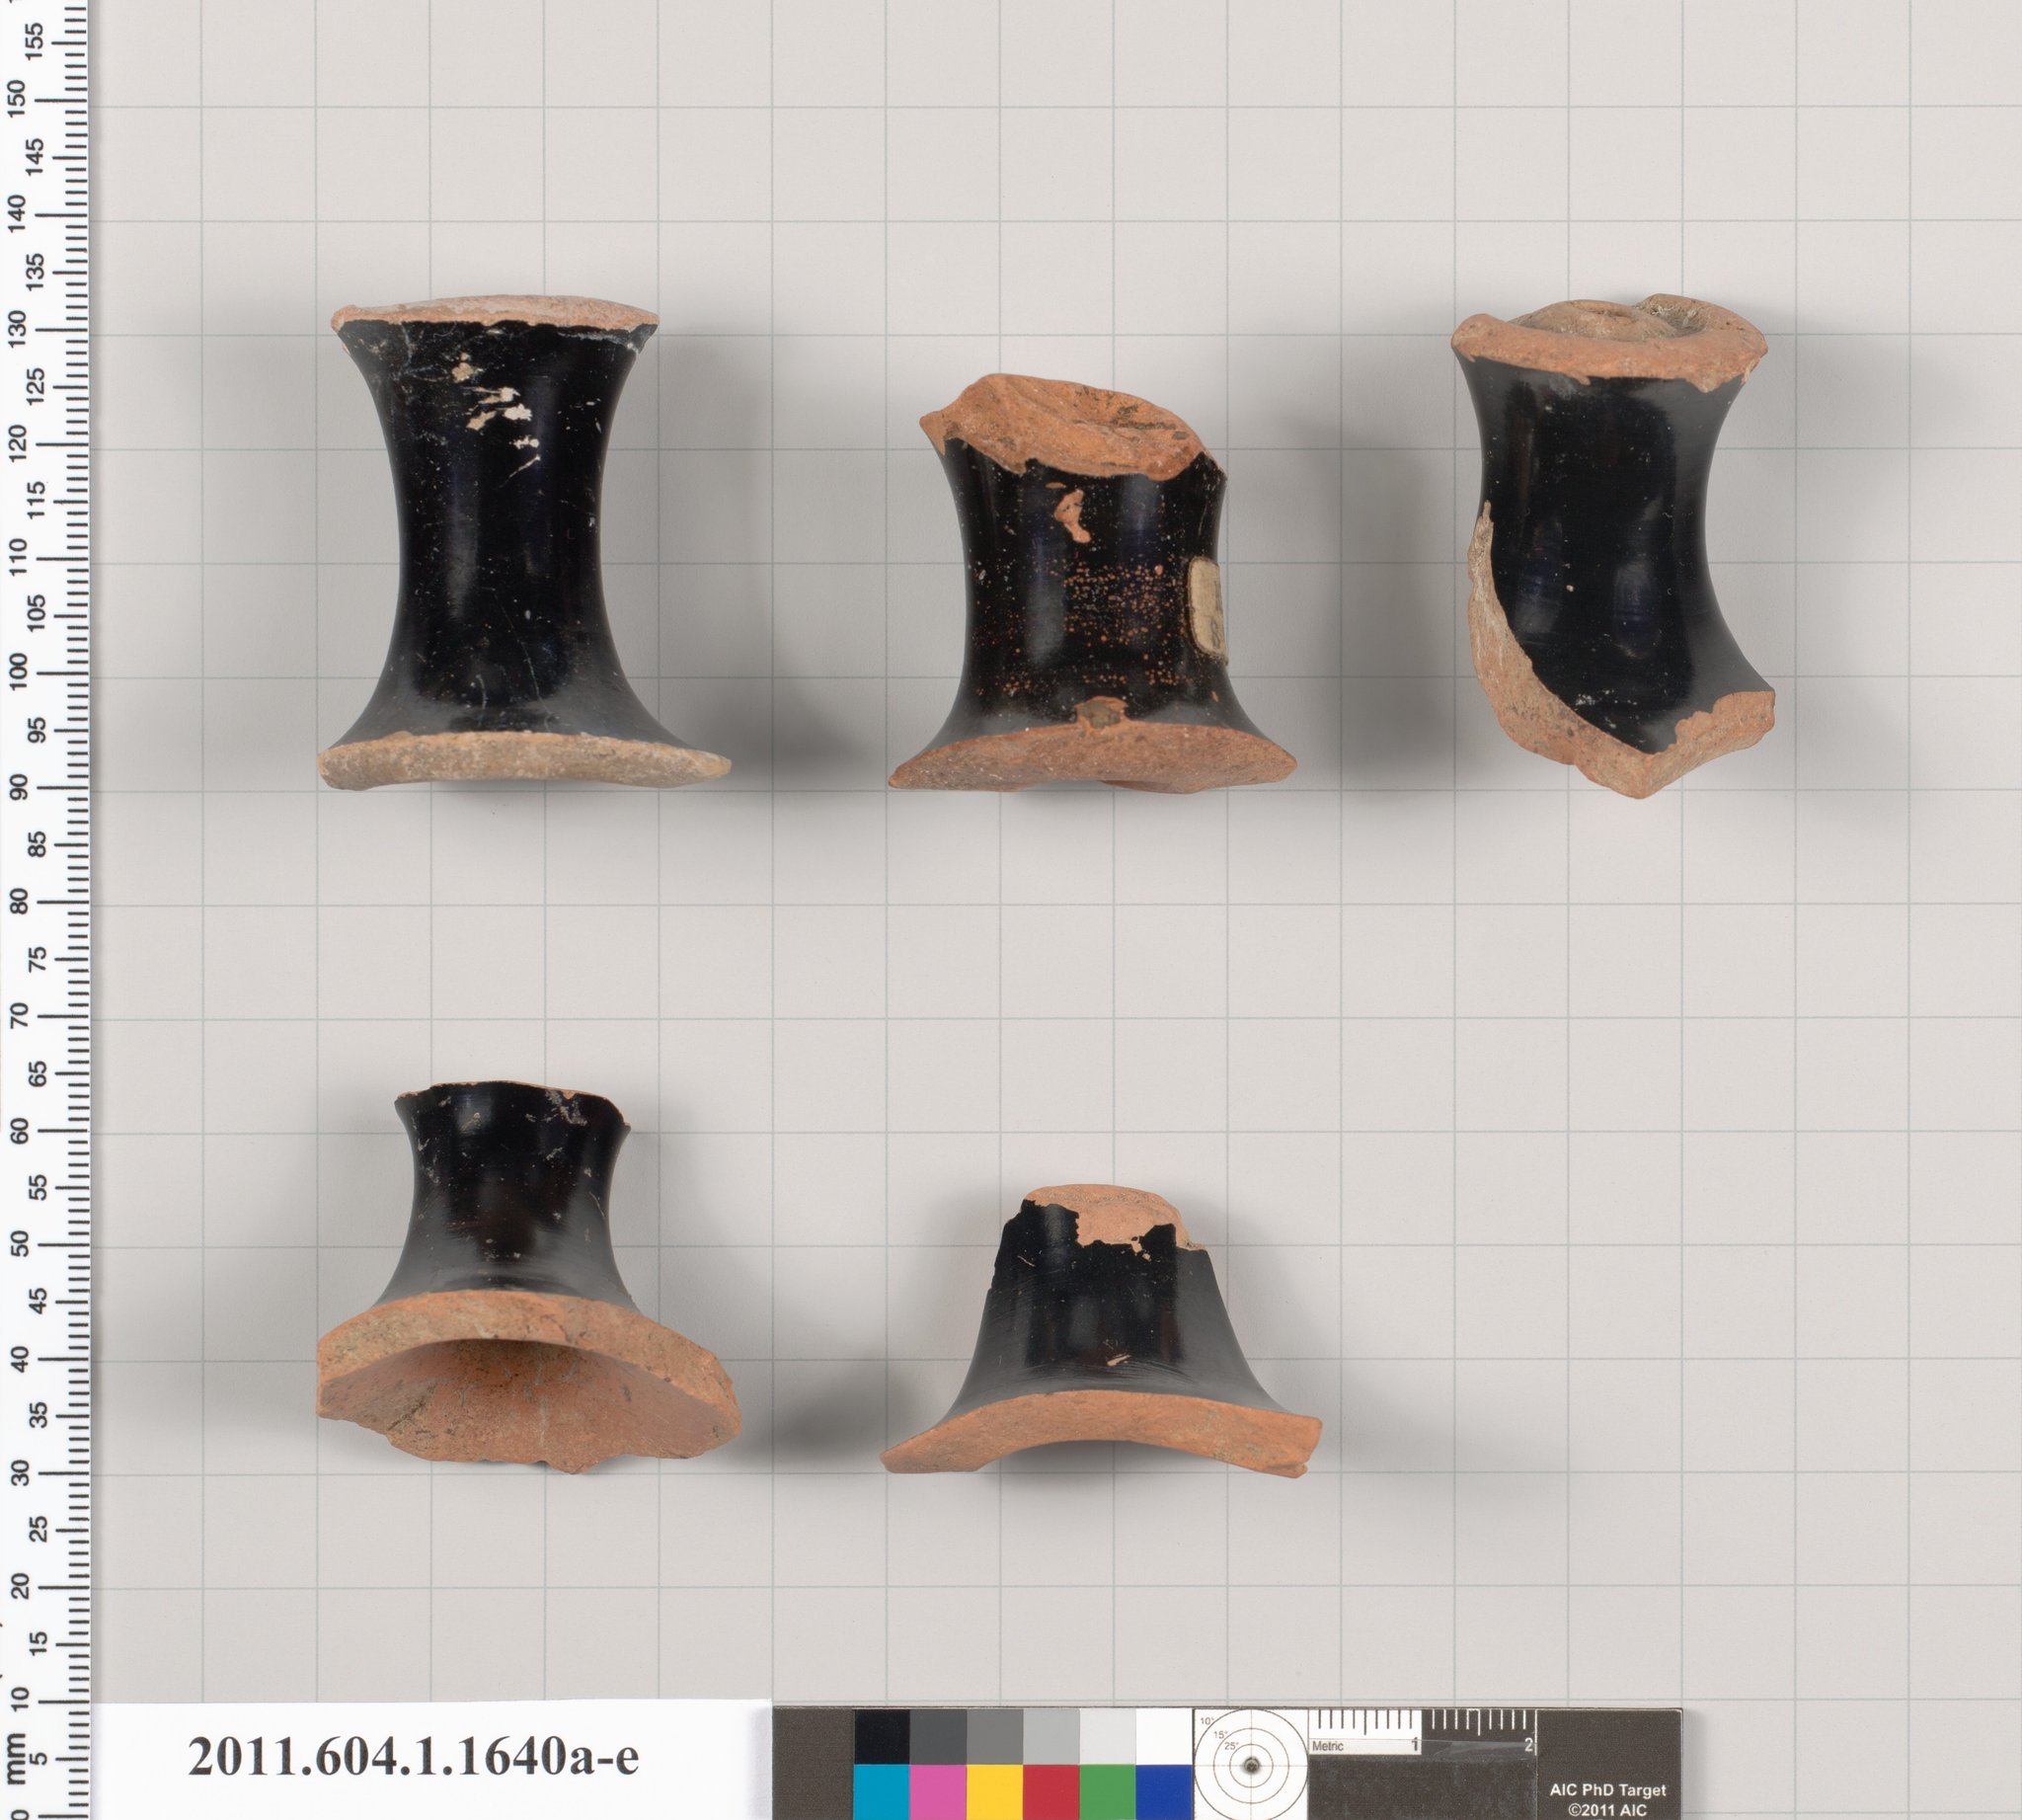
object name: kylix fragment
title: Terracotta fragments of kylikes (drinking cups)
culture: greek, attic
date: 500-401 BCE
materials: terracotta